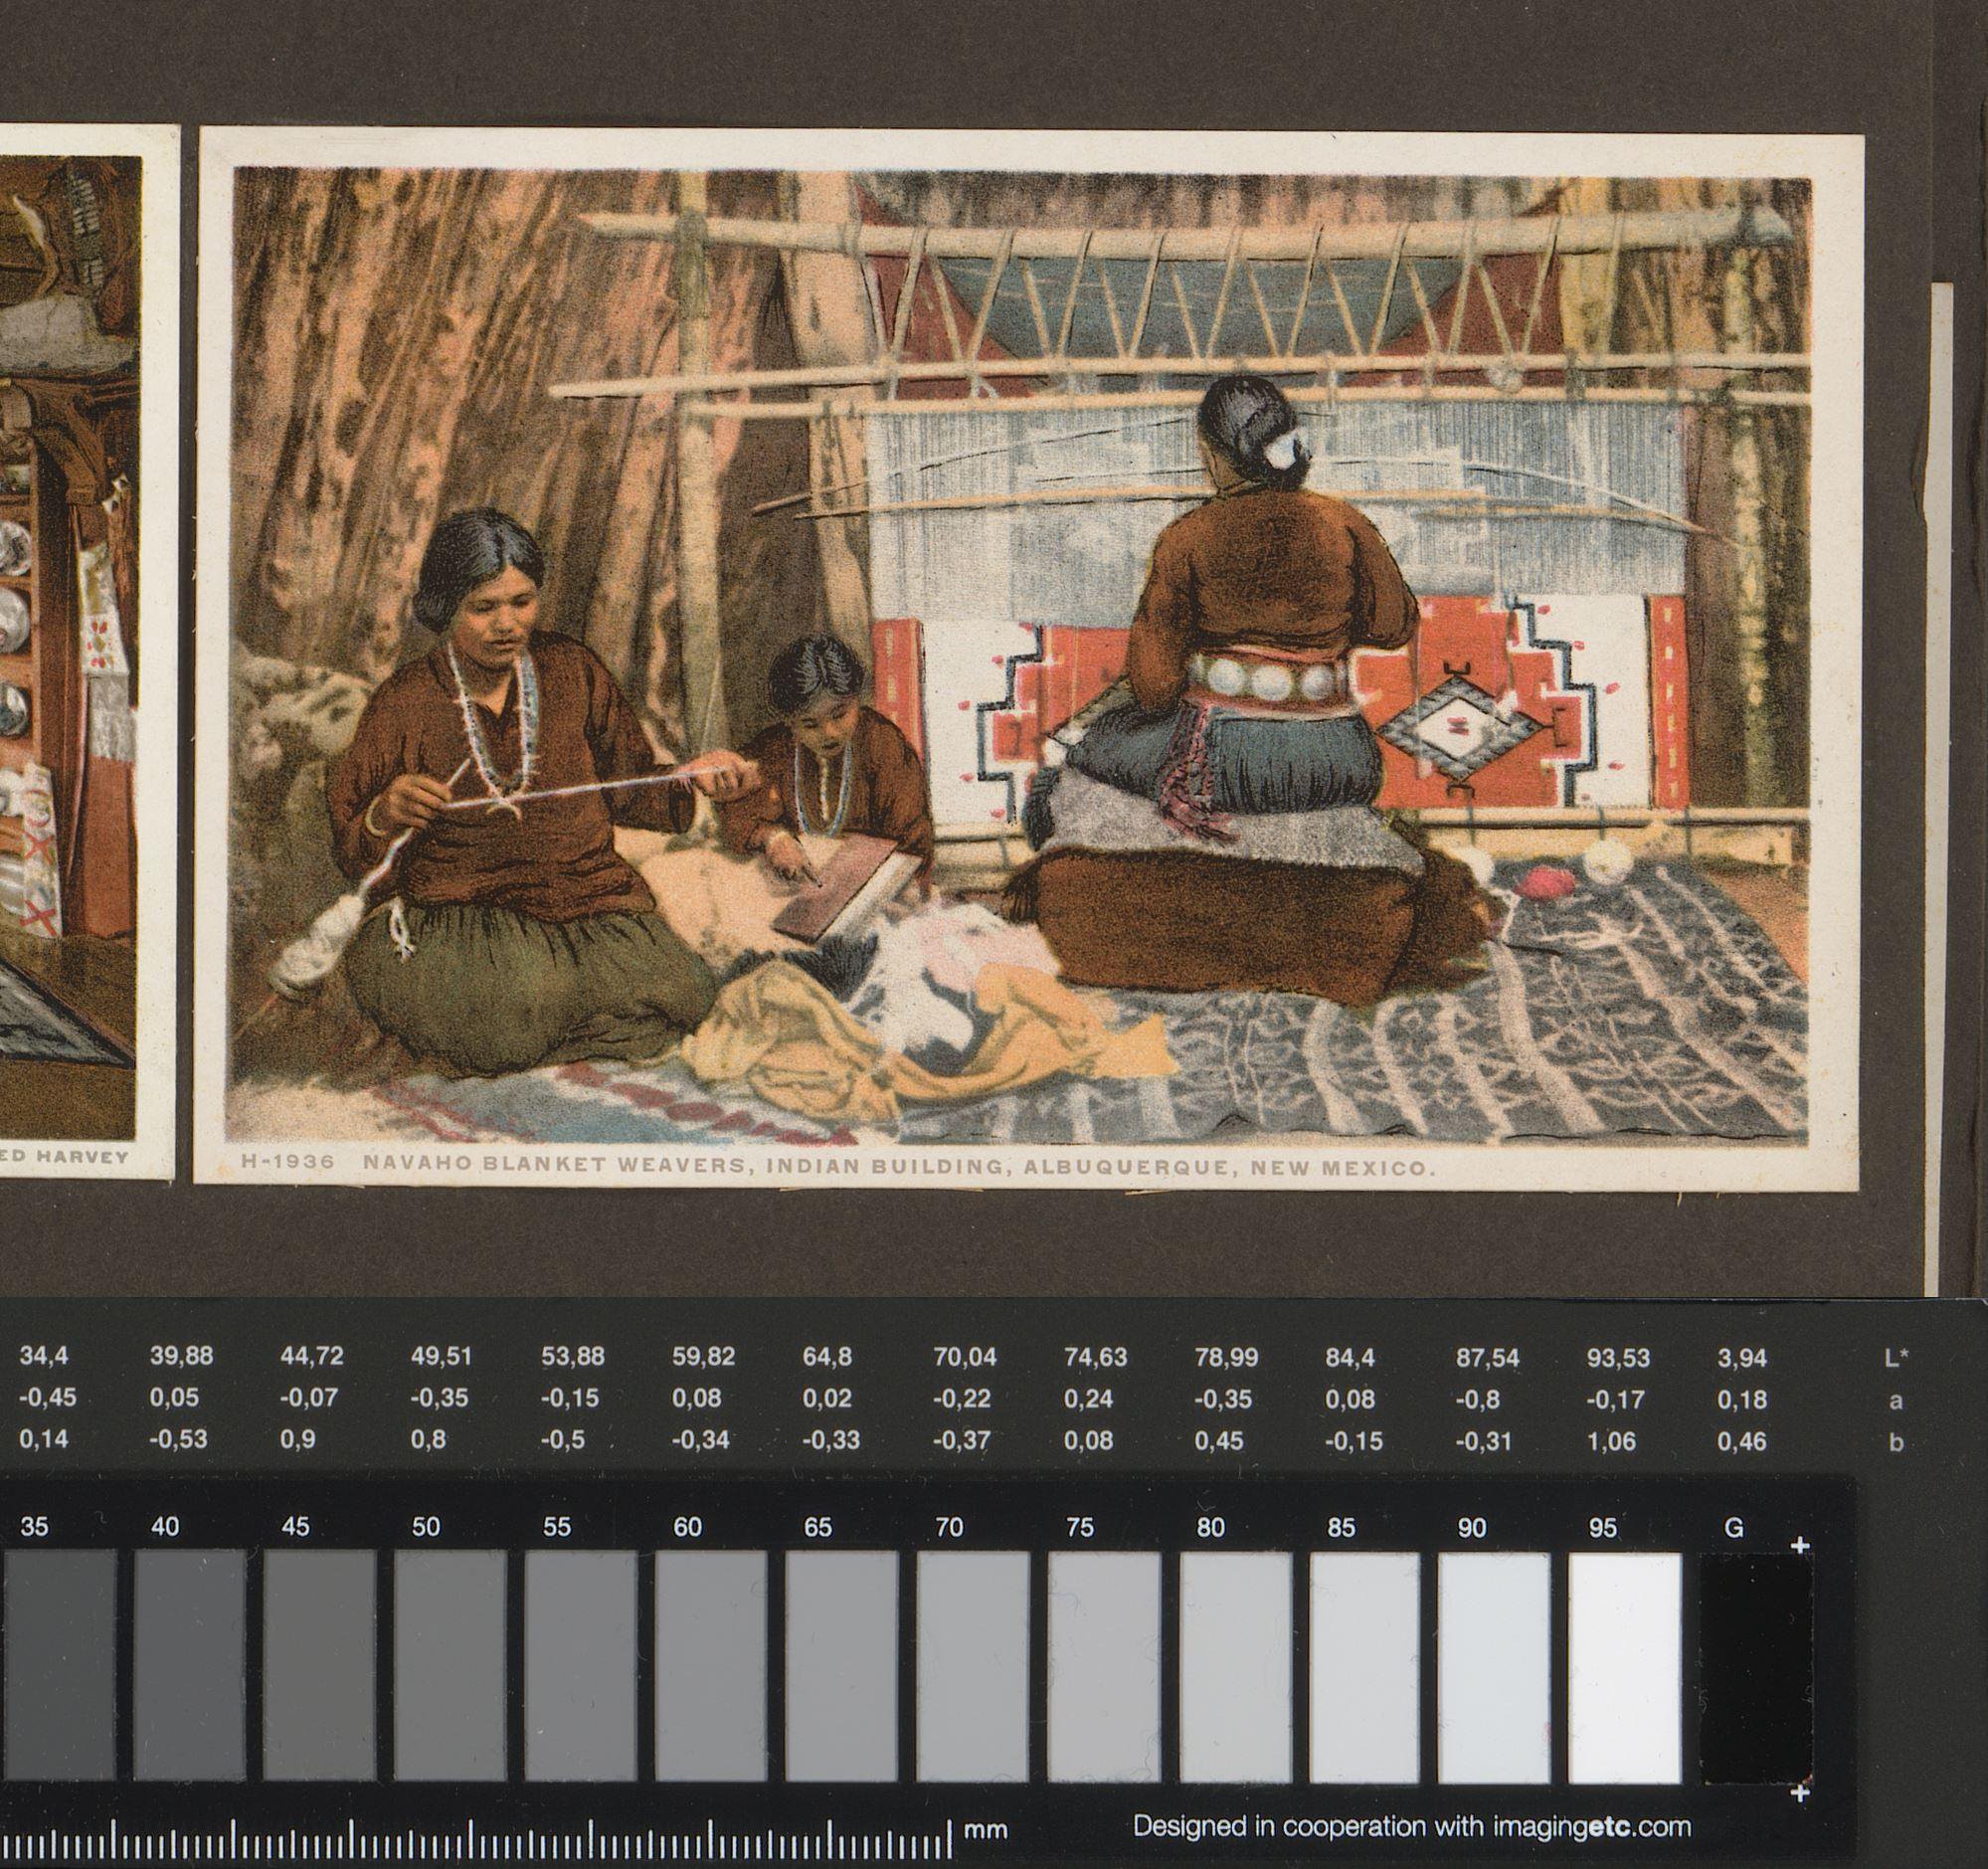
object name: ansichtkaart, prentbriefkaart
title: Navajo blanket weavers, Indian building, Albuquerque, New Mexico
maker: Anonymous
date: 1928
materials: paper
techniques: chromolithography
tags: indigenous peoples of north america, tapestry weaver, gobelin maker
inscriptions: number: ‘H-1936’